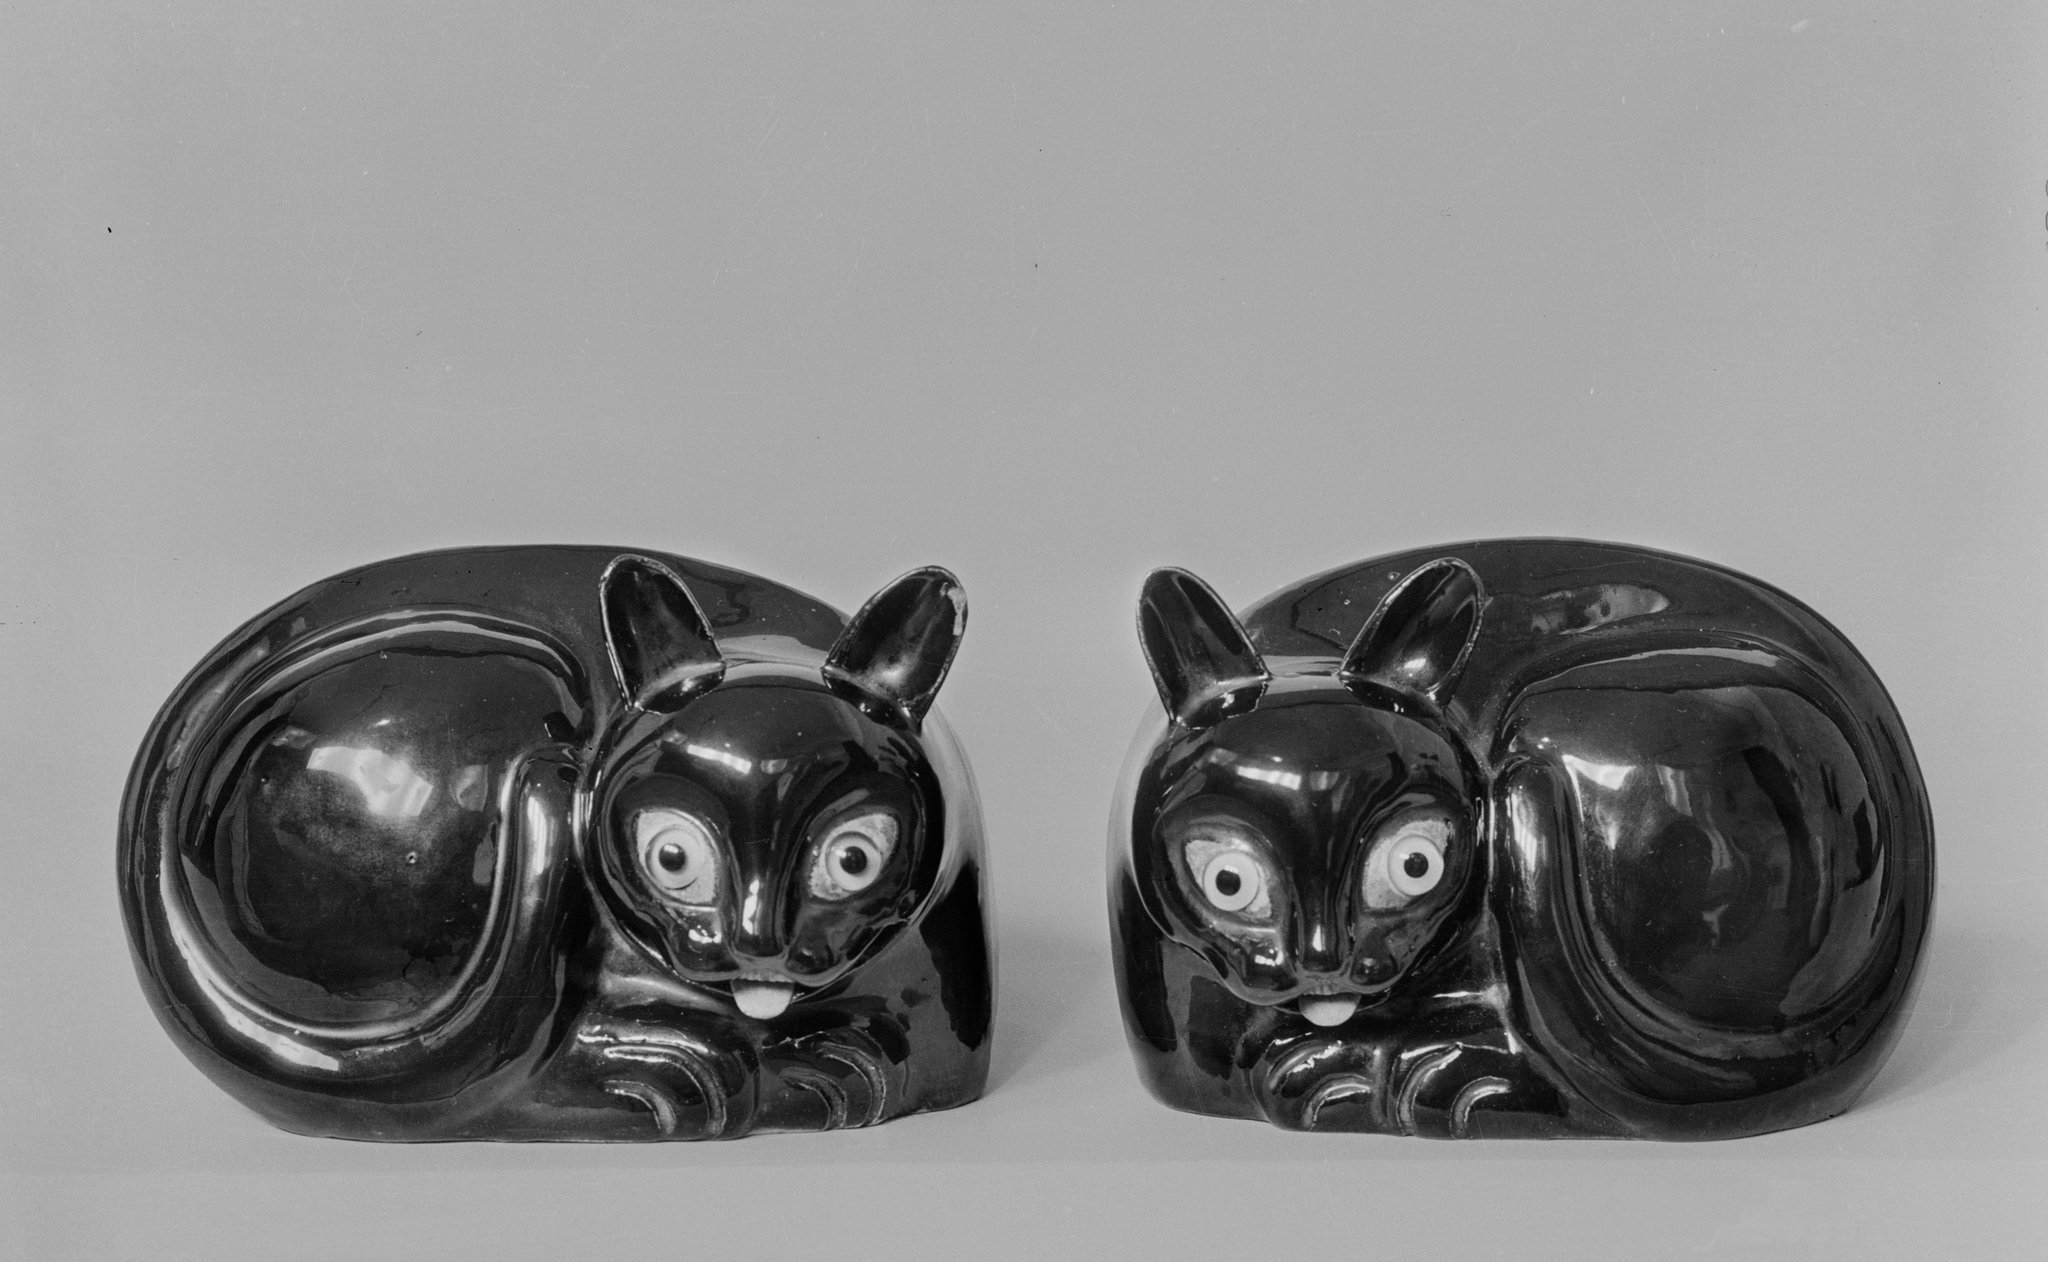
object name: cat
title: Cat (one of a pair)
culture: chinese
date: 1701-1800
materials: enamel, plastic, porcelain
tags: cats